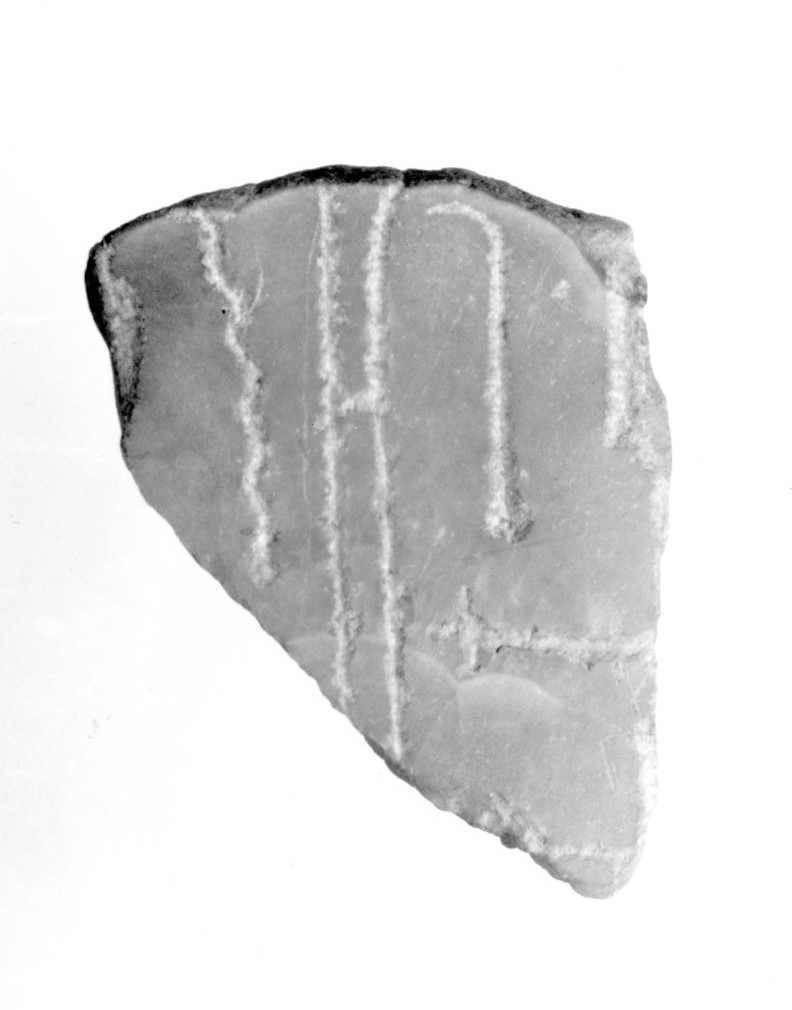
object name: canopic chest, tiye, thutmose iv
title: Fragment of a Canopic Chest of Queen Tiya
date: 1427-1390 BCE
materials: stone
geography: egypt